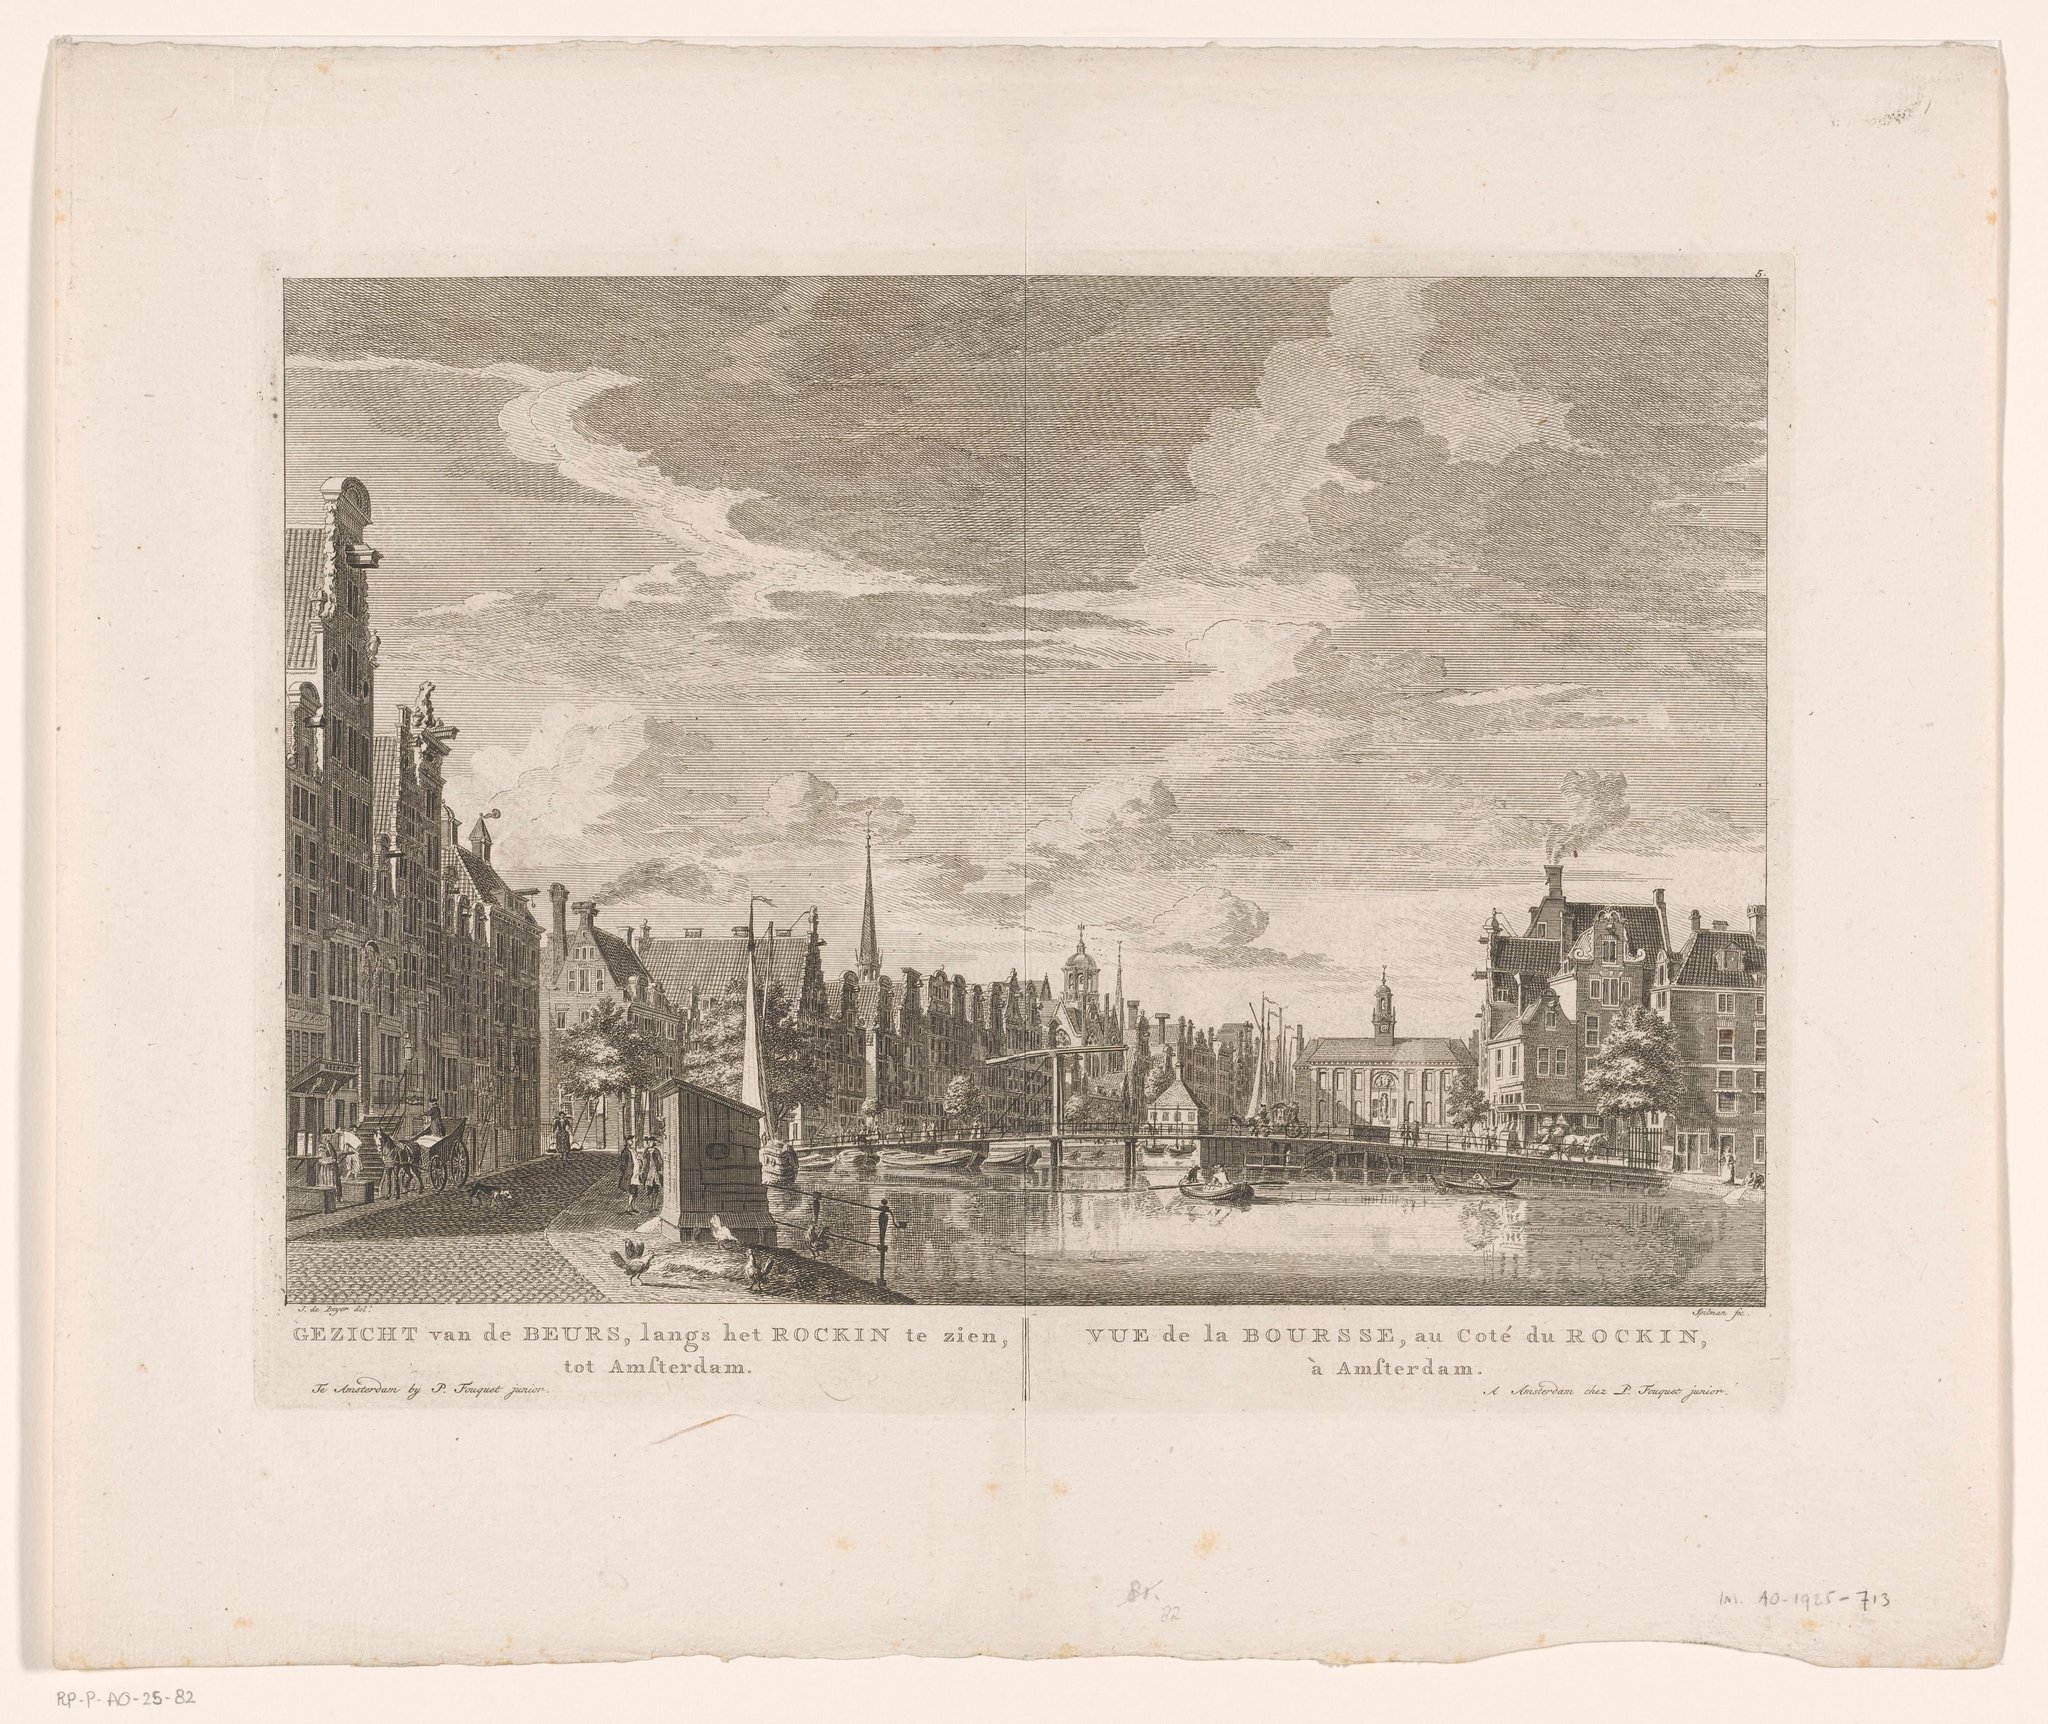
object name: print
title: Gezicht van de Beurs, langs het Rockin te zien, tot Amsterdam / Vue de la Boursse, au coté du Rockin, à Amsterdam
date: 1760-1783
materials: paper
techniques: engraving, etching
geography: amsterdam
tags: bridge in city across river, canal, etc. (+ city(-scape) with figures, staffage), stock exchange, stock-market, church (exterior) - qq - small church, chapel, canals, waters (in city) (+ city(-scape) with figures, staffage), street (+ city(-scape) with figures, staffage)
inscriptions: collector's mark: Lugt 2228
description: Deze prent is ook gebruikt in de zogenaamde Atlas van Fouquet.* Pierre Fouquet gaf vanaf 1760 stadsgezichten van Amsterdam - naar tekeningen van verschillende kunstenaars, gemaakt door verschillende prentmakers - uit. Deze prenten werden aanvankelijk los of in series verkocht. Zoals toen gebruikelijk kon de koper de prenten zelf laten inbinden. Hiertoe gaf Fouquet tussen 1778 en 1783 een titelblad, plattegrond en inhoudsopgave van de tot dusver 100 uitgegeven prenten uit (1). Gezien de inhoud afhankelijk was van wat de koper had verzameld verschilt de inhoud van de verschillende bewaarde Fouquetatlassen onder deze titel sterk. Ook zijn er exemplaren bekend waar tevens andere prenten aan zijn toegevoegd. Omdat er behoefte bleek aan uitleg bij de platen werd in 1783 een nieuwe versie van de atlas uitgegeven, aangevuld met tekst en twee prenten. De aangegeven volgorde veranderde maar de platen van de al eerder uitgegeven prenten bleven ongewijzigd. Deze uitgave werd in opdracht van Fouquet gedrukt bij Daniël Jean Changuion en Petrus den Hengst (2). Een tiental platen werd bijgewerkt en verscheen, met nieuw impressum, in het vervolg van Wagenaars geschiedenis van Amsterdam, uitgeven door Petrus Conradi en Folkert van der Plaats (3). Een aantal jaar na het overlijden van Fouquet kwam Evert Maaskamp met een nieuwe uitgave van de atlas, met verbeterde tekst en toevoeging van twee prenten. Op alle platen verwijderde hij het oude en liet hij zijn eigen impressum zetten (4). De huidige staat van de prent komt voor in exemplaren van de onder (1) en (2) genoemde werken. * Onder de Atlas van Fouquet of Fouquetatlas verstaan we de hieronder vermelde publicaties (1), (2) en (4). (1). Afbeeldingen van de wyd-vermaarde koopstad Amsterdam benevens des zelvs voornaamste gebouwen en gezigten alle naar het leeven getekend / Receuil des edifices les plus considerables et des plus belles vues, de la fameuse ville d'Amsterdam, dessinées d'après nature. Amsterdam: Pierre Fouquet, 1778-1783. (2). Nieuwe atlas, van de voornaamste gebouwen en gezigten der stad Amsterdam, met derzelver beknopte beschryvingen. 2 delen. Amsterdam: Daniël Jean Changuion en Petrus den Hengst [in opdracht van Pierre Fouquet], 1783. (3). Stijl, Simon. Amsterdam, in zyne geschiedenissen, voorregten, koophandel, gebouwen, kerkenstaat, schoolen, schutterye, gilden en regeeringe, beschreeven. Om te dienen ten vervolge op het werk van Jan Wagenaar (…). 10 delen. Amsterdam en Harlingen: Petrus Conradi en Folkert van der Plaats, 1788-1801. (4). Nieuwe atlas, van de voornaamste gebouwen en gezigten der stad Amsterdam. Met derzelver beknopte beschryvingen. Amsterdam: Evert Maaskamp, 1805. * Het aantal vermelde staten is gebaseerd op het aantal gevonden staten. Mogelijk zijn er meer staten van deze prent. Zie RP-P-1905-4008 voor eerdere staat.